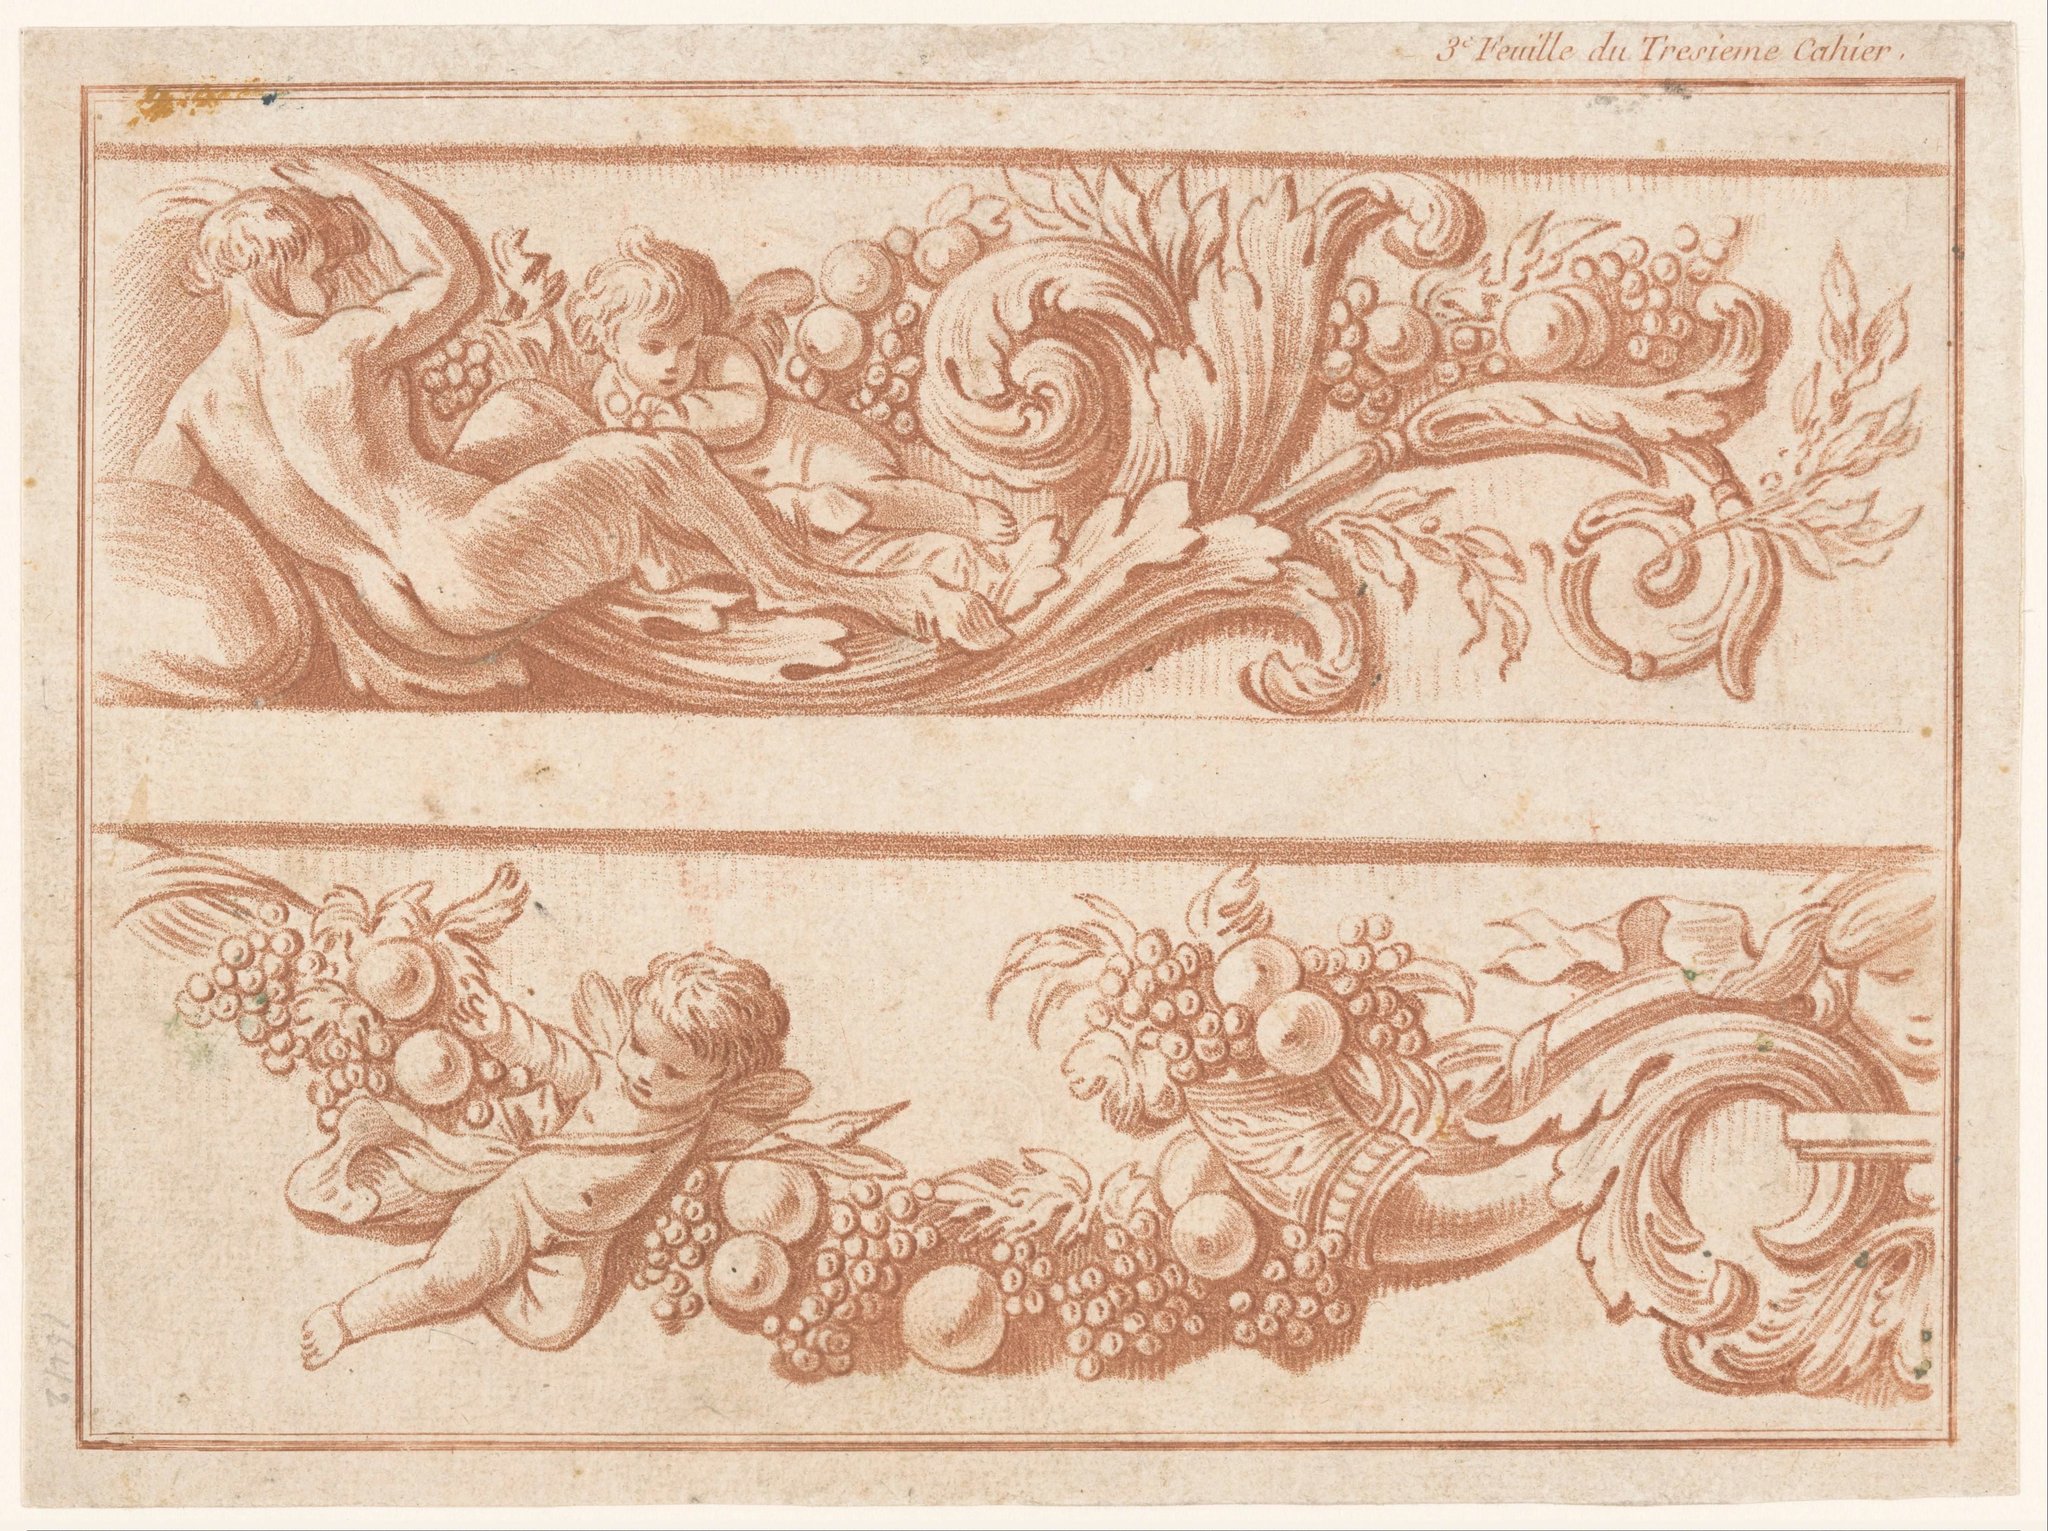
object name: ornament print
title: Twee friezen met putti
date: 1770-1780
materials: paper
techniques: printmaking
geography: paris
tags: cupids: 'amores', 'amoretti', 'putti'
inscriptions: collector's mark: Lugt 2228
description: Twee friezen met putti, druiventrossen en een hoorn des overvloeds.